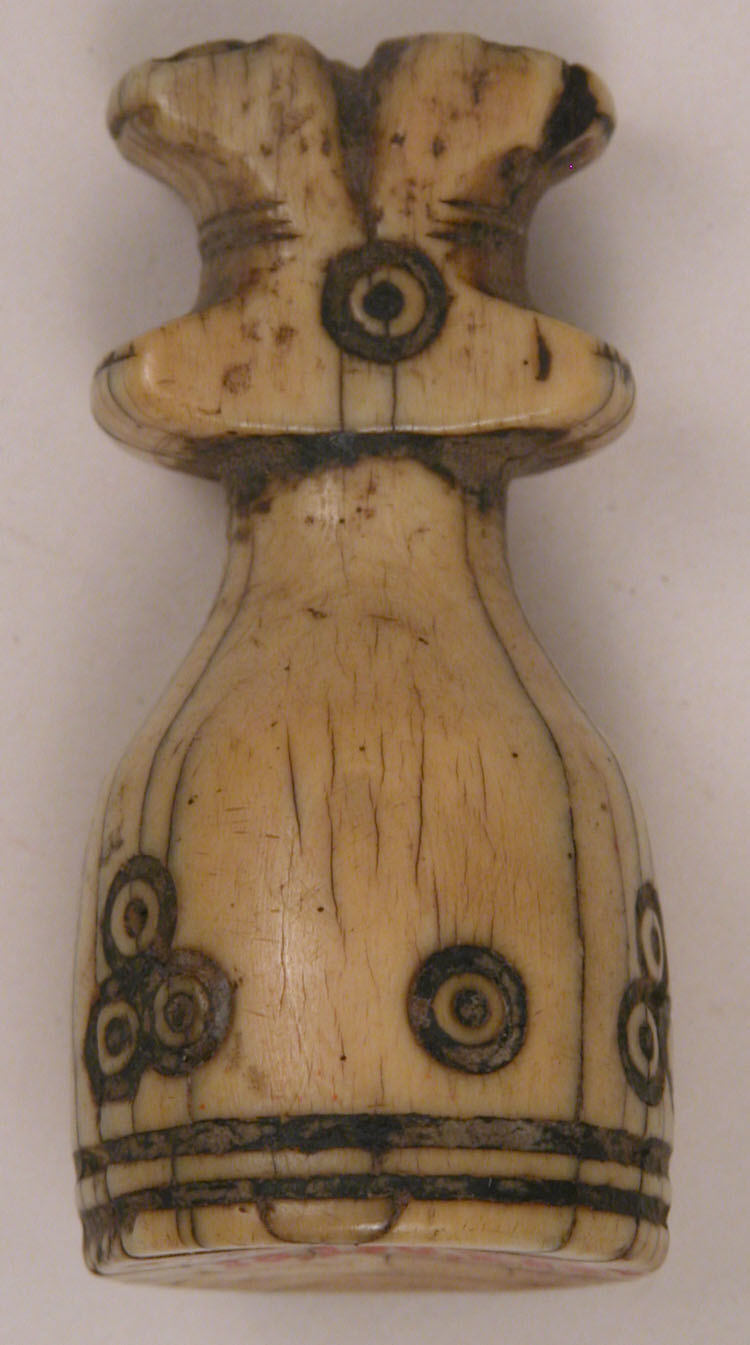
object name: chess piece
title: Chess Piece, Rook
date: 701-1000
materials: ivory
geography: western islamic lands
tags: chess,games